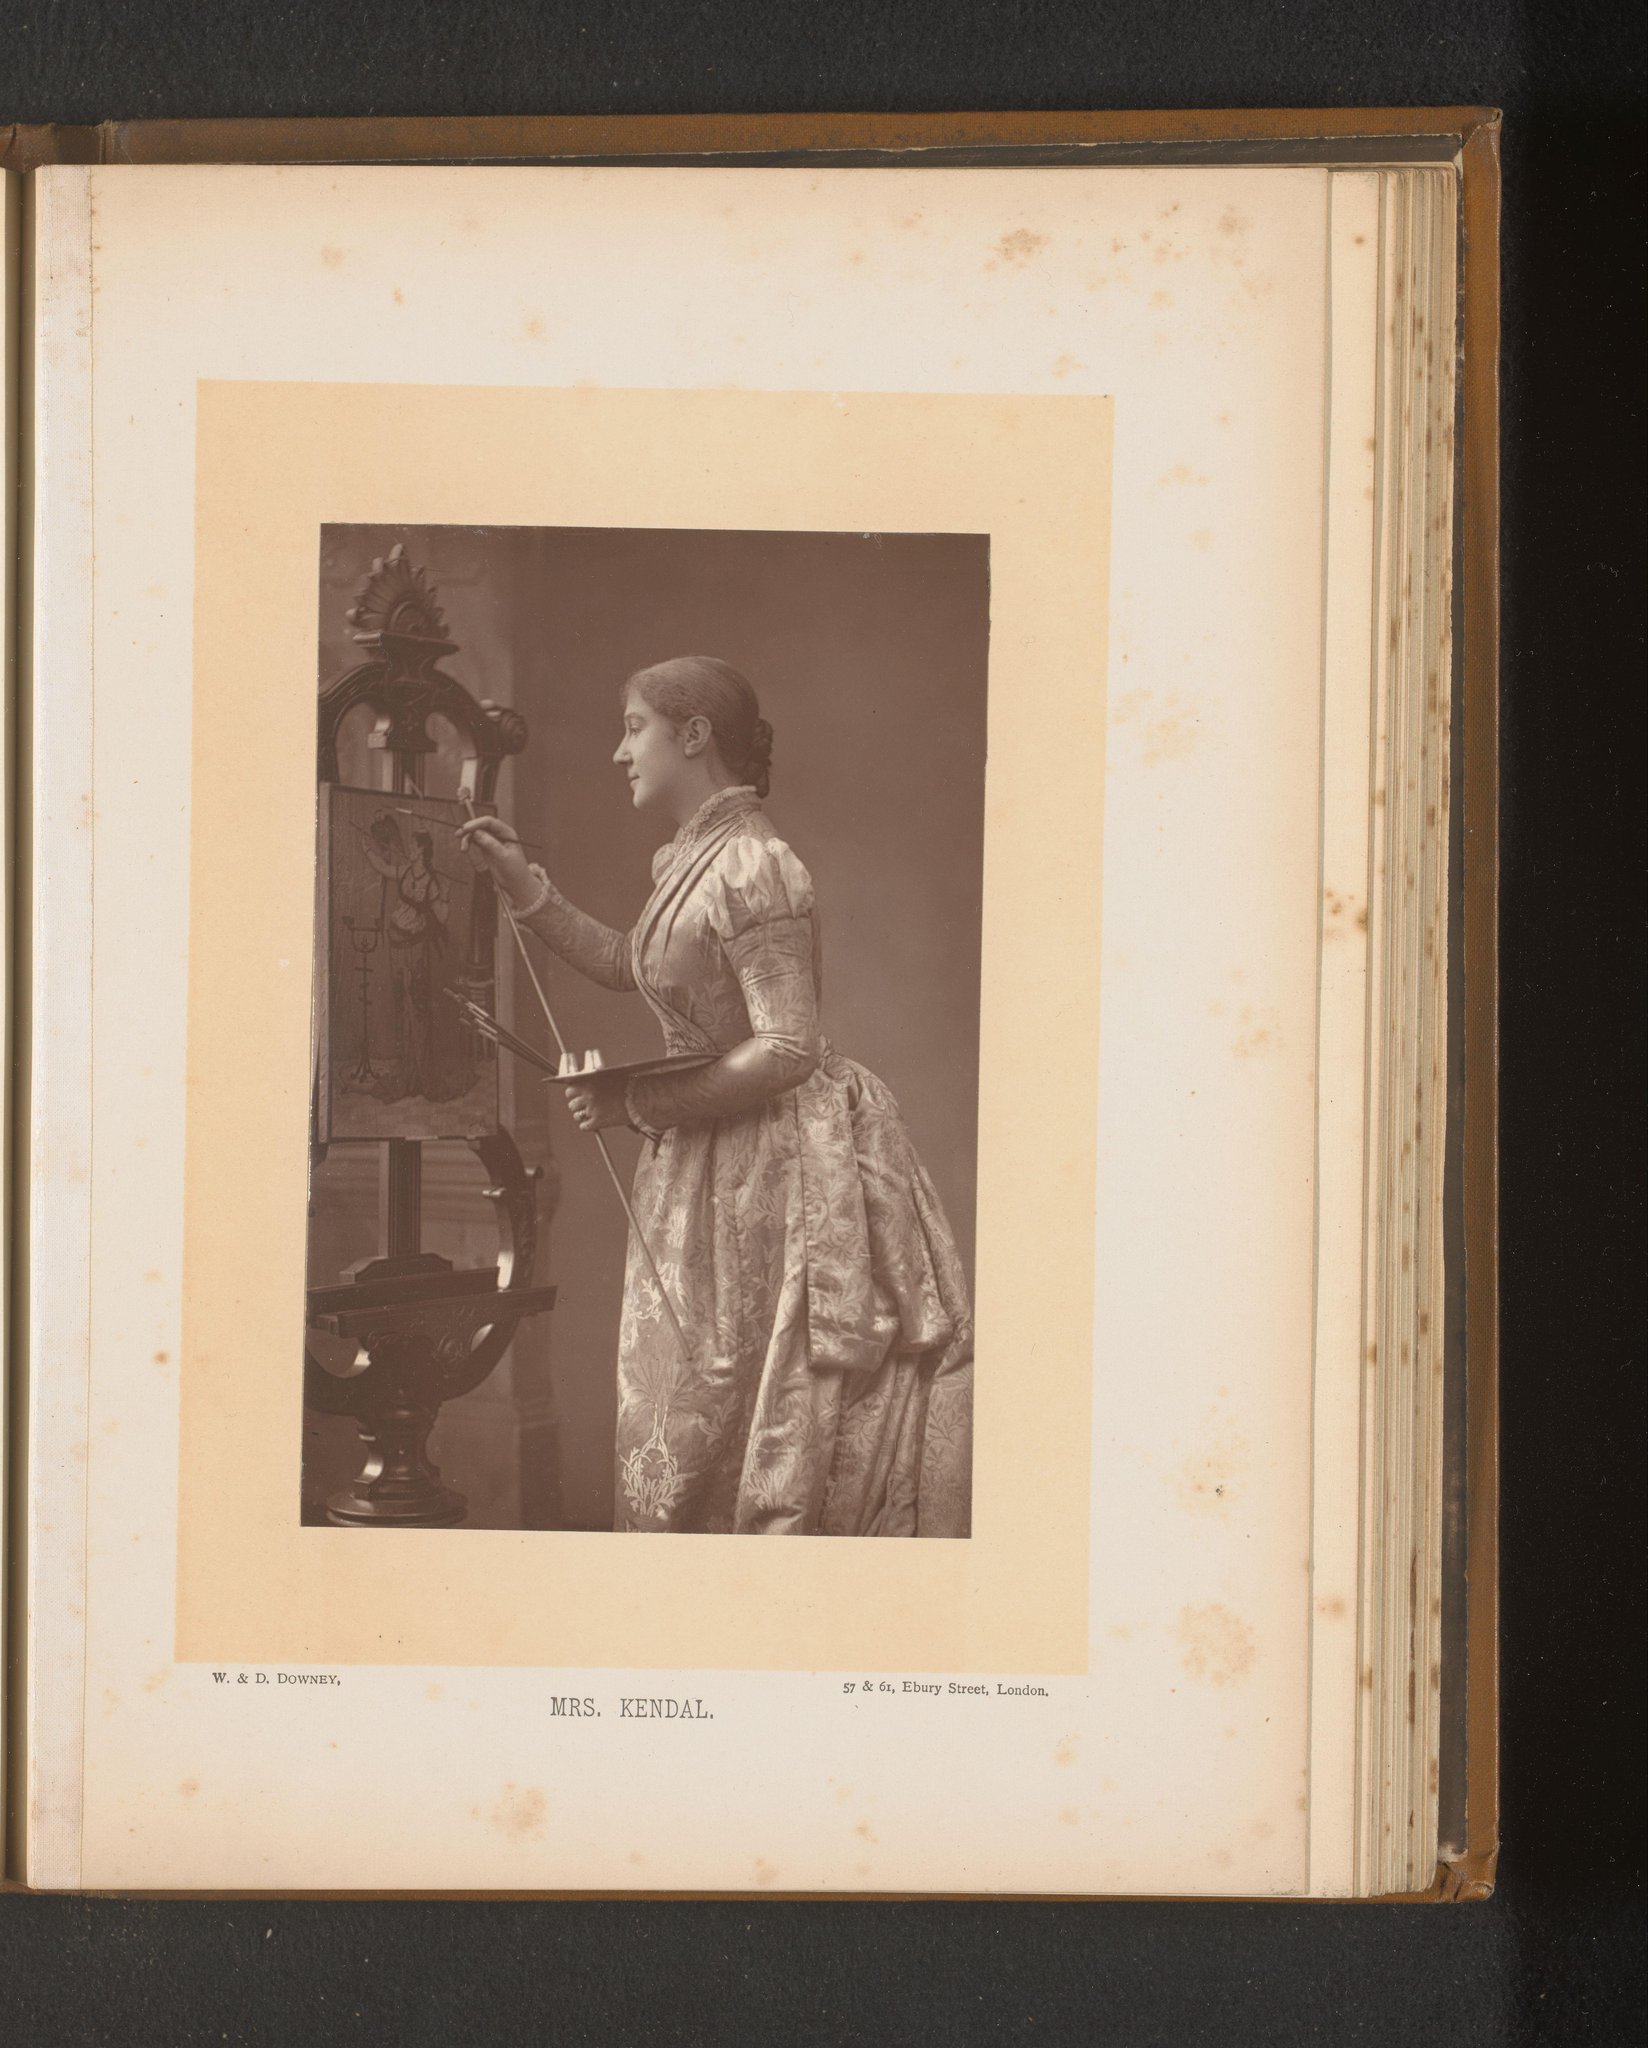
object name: photomechanical print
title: Portret van Madge Kendal achter een schildersezel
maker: Anonymous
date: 1881-1891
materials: paper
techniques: woodburytype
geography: london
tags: portrait of actor, actress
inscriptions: inscription: ‘57 & 61, Elbury Street, London.’